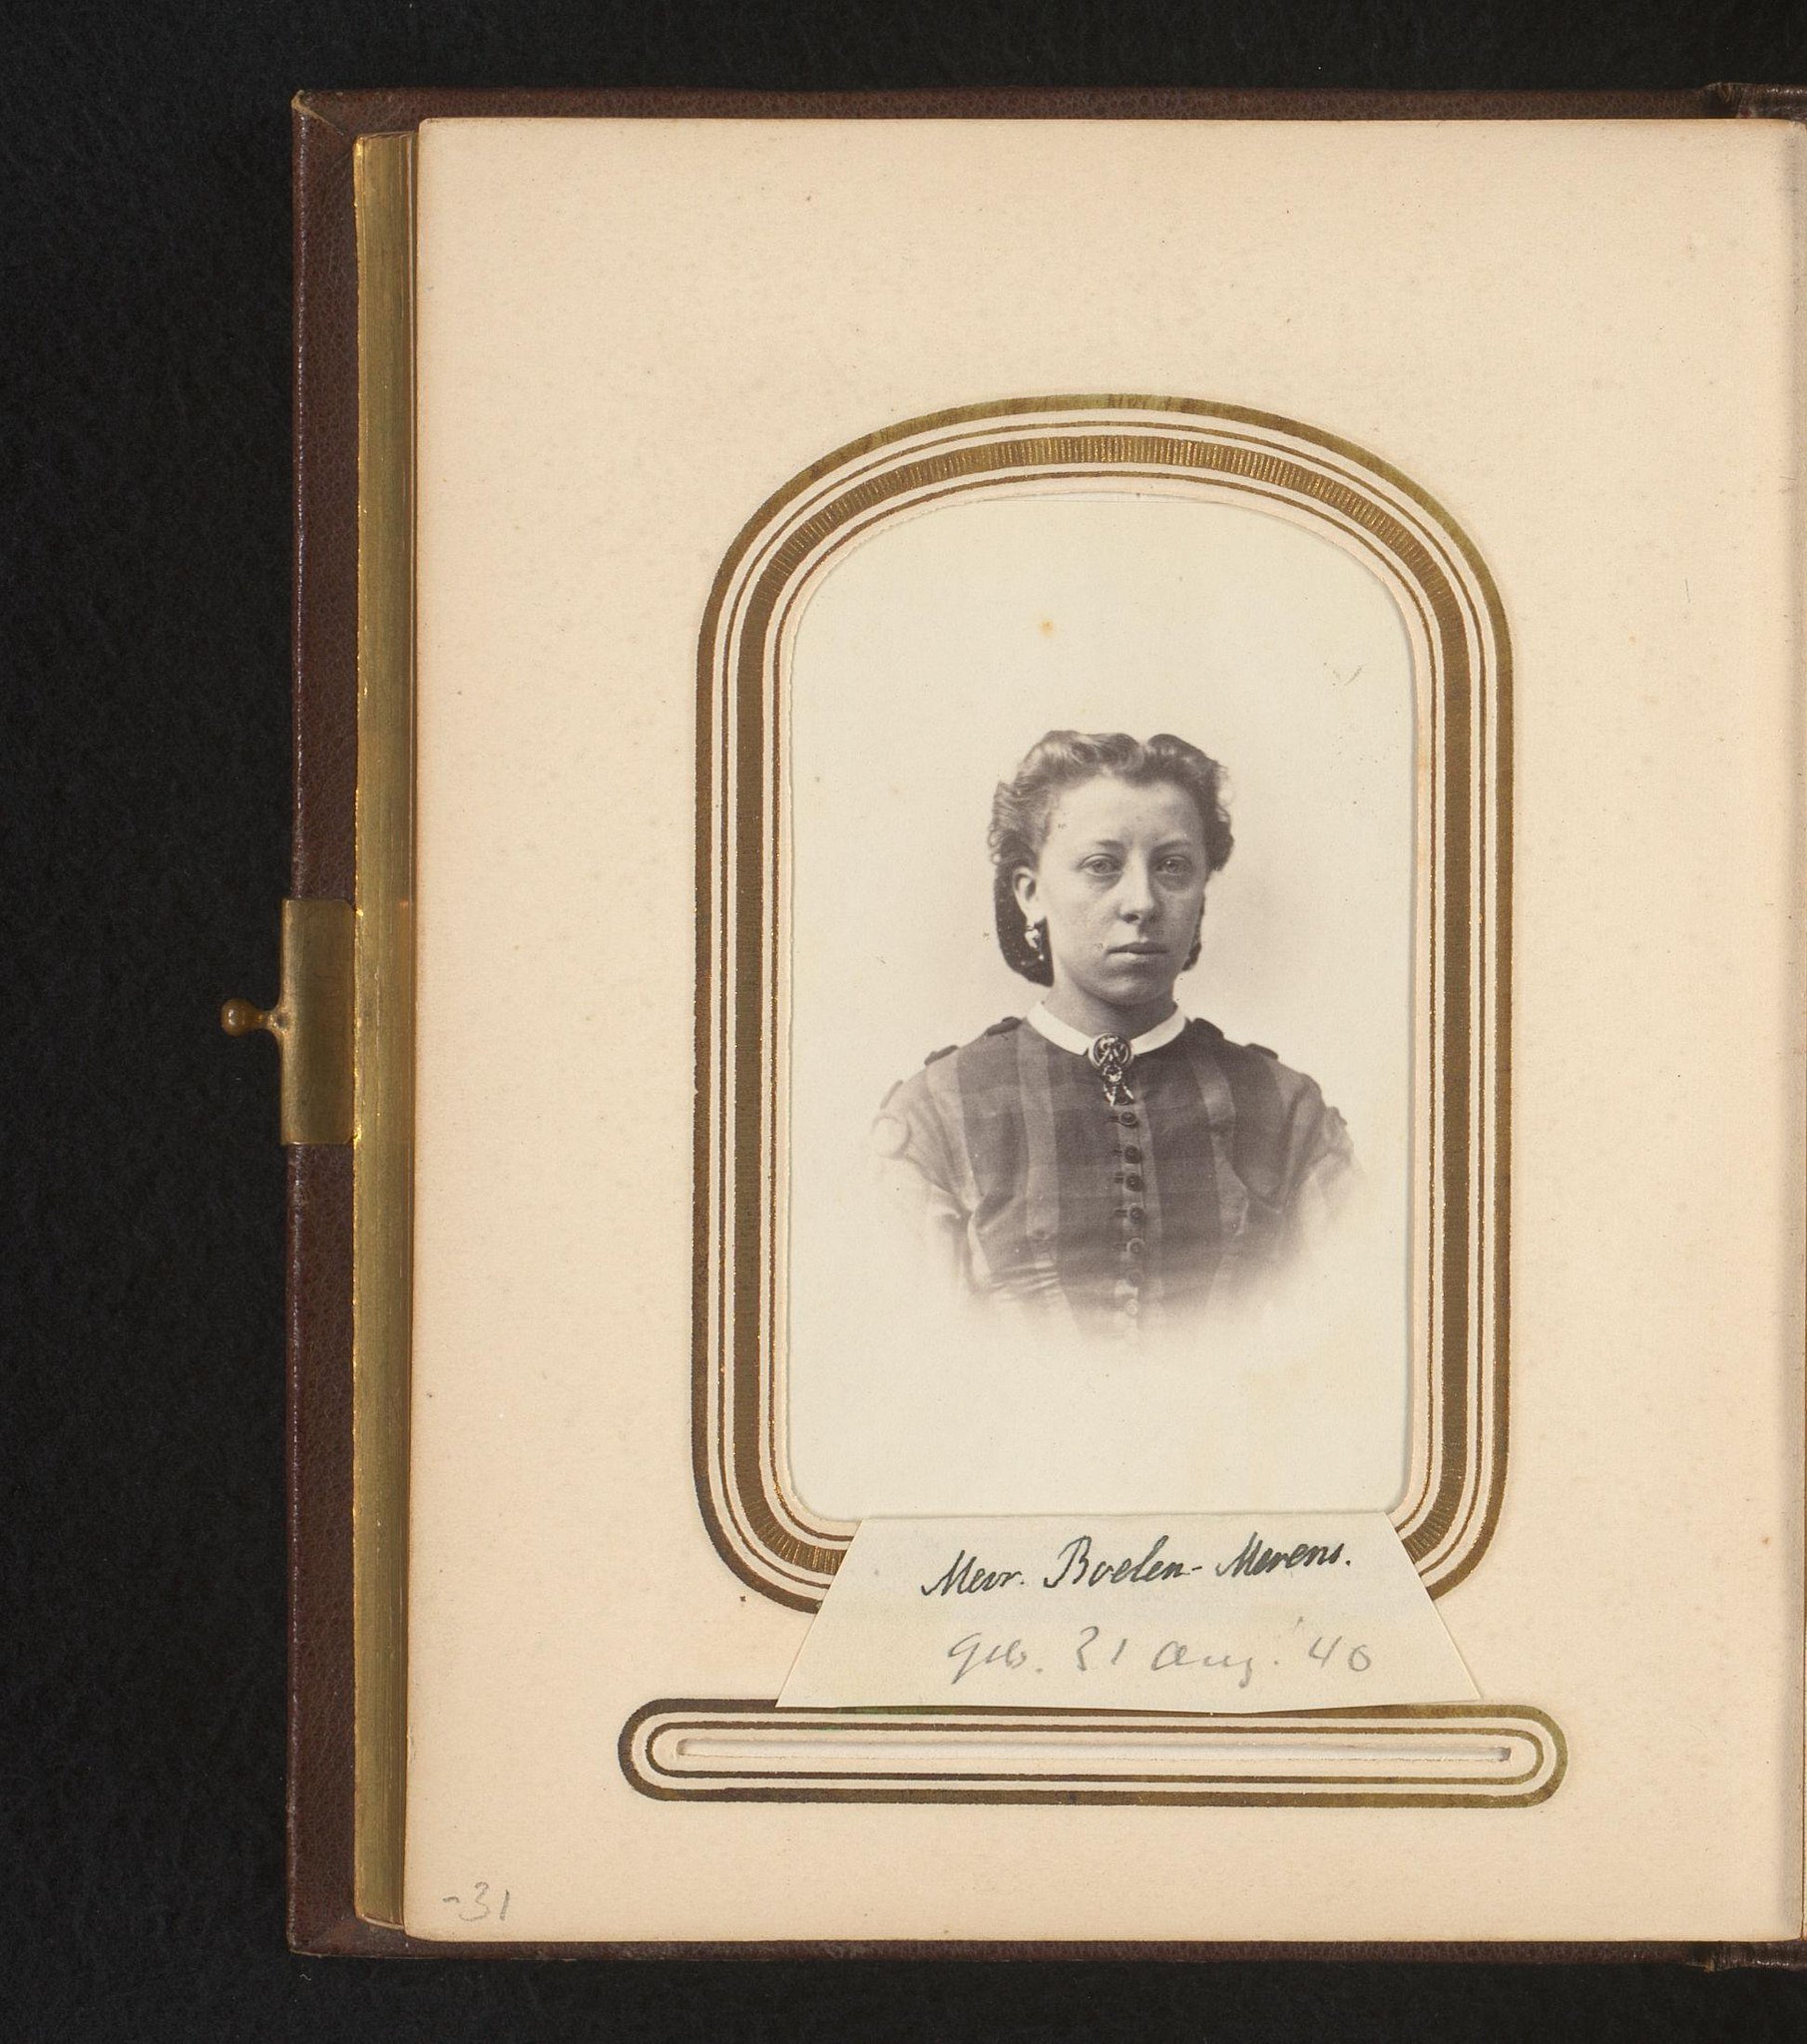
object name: photograph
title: Mevr. Boelen-Merens, geb. 31 aug. '40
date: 1864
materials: cardboard, paper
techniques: albumen print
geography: amsterdam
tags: the hague, historical persons - bb - woman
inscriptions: address: ‘AMSTERDAM/ Achtergracht bij den Amstel/ Z 183.’